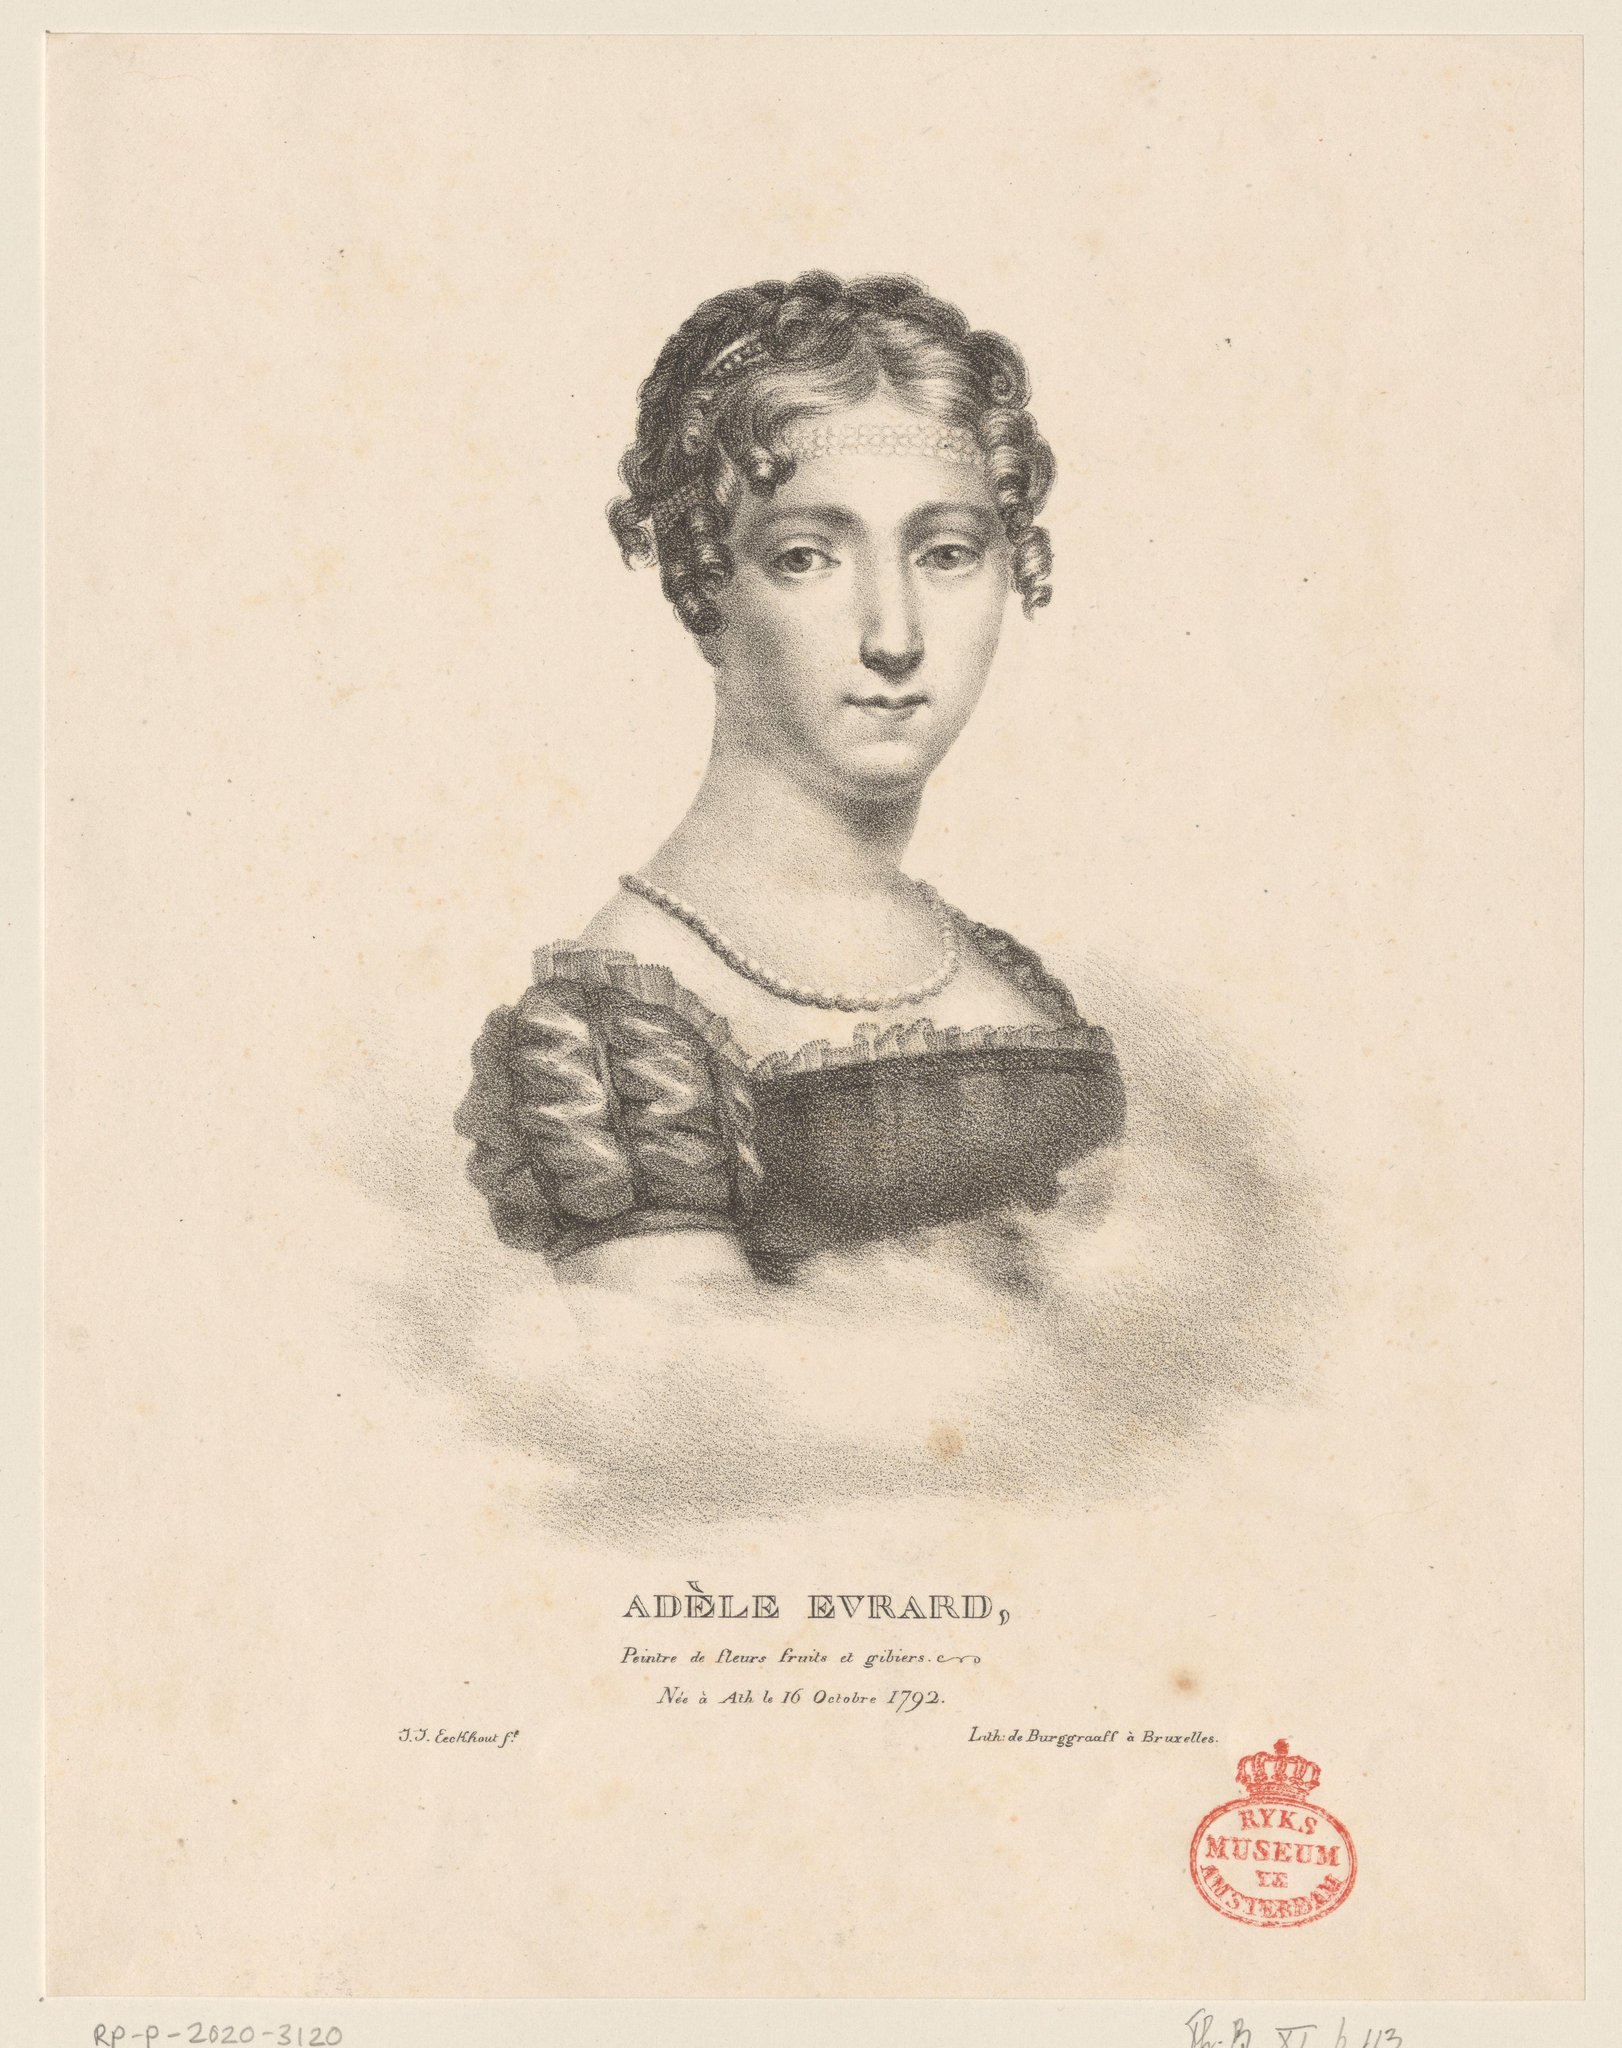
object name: print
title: Portretten van hedendaagse kunstenaars uit het Verenigd Koninkrijk der Nederlanden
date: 1822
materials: paper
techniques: lithograph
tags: painter, adèle agnès evrard, historical persons - bb - woman, portrait, self-portrait of painter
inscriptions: collector's mark: Lugt 12